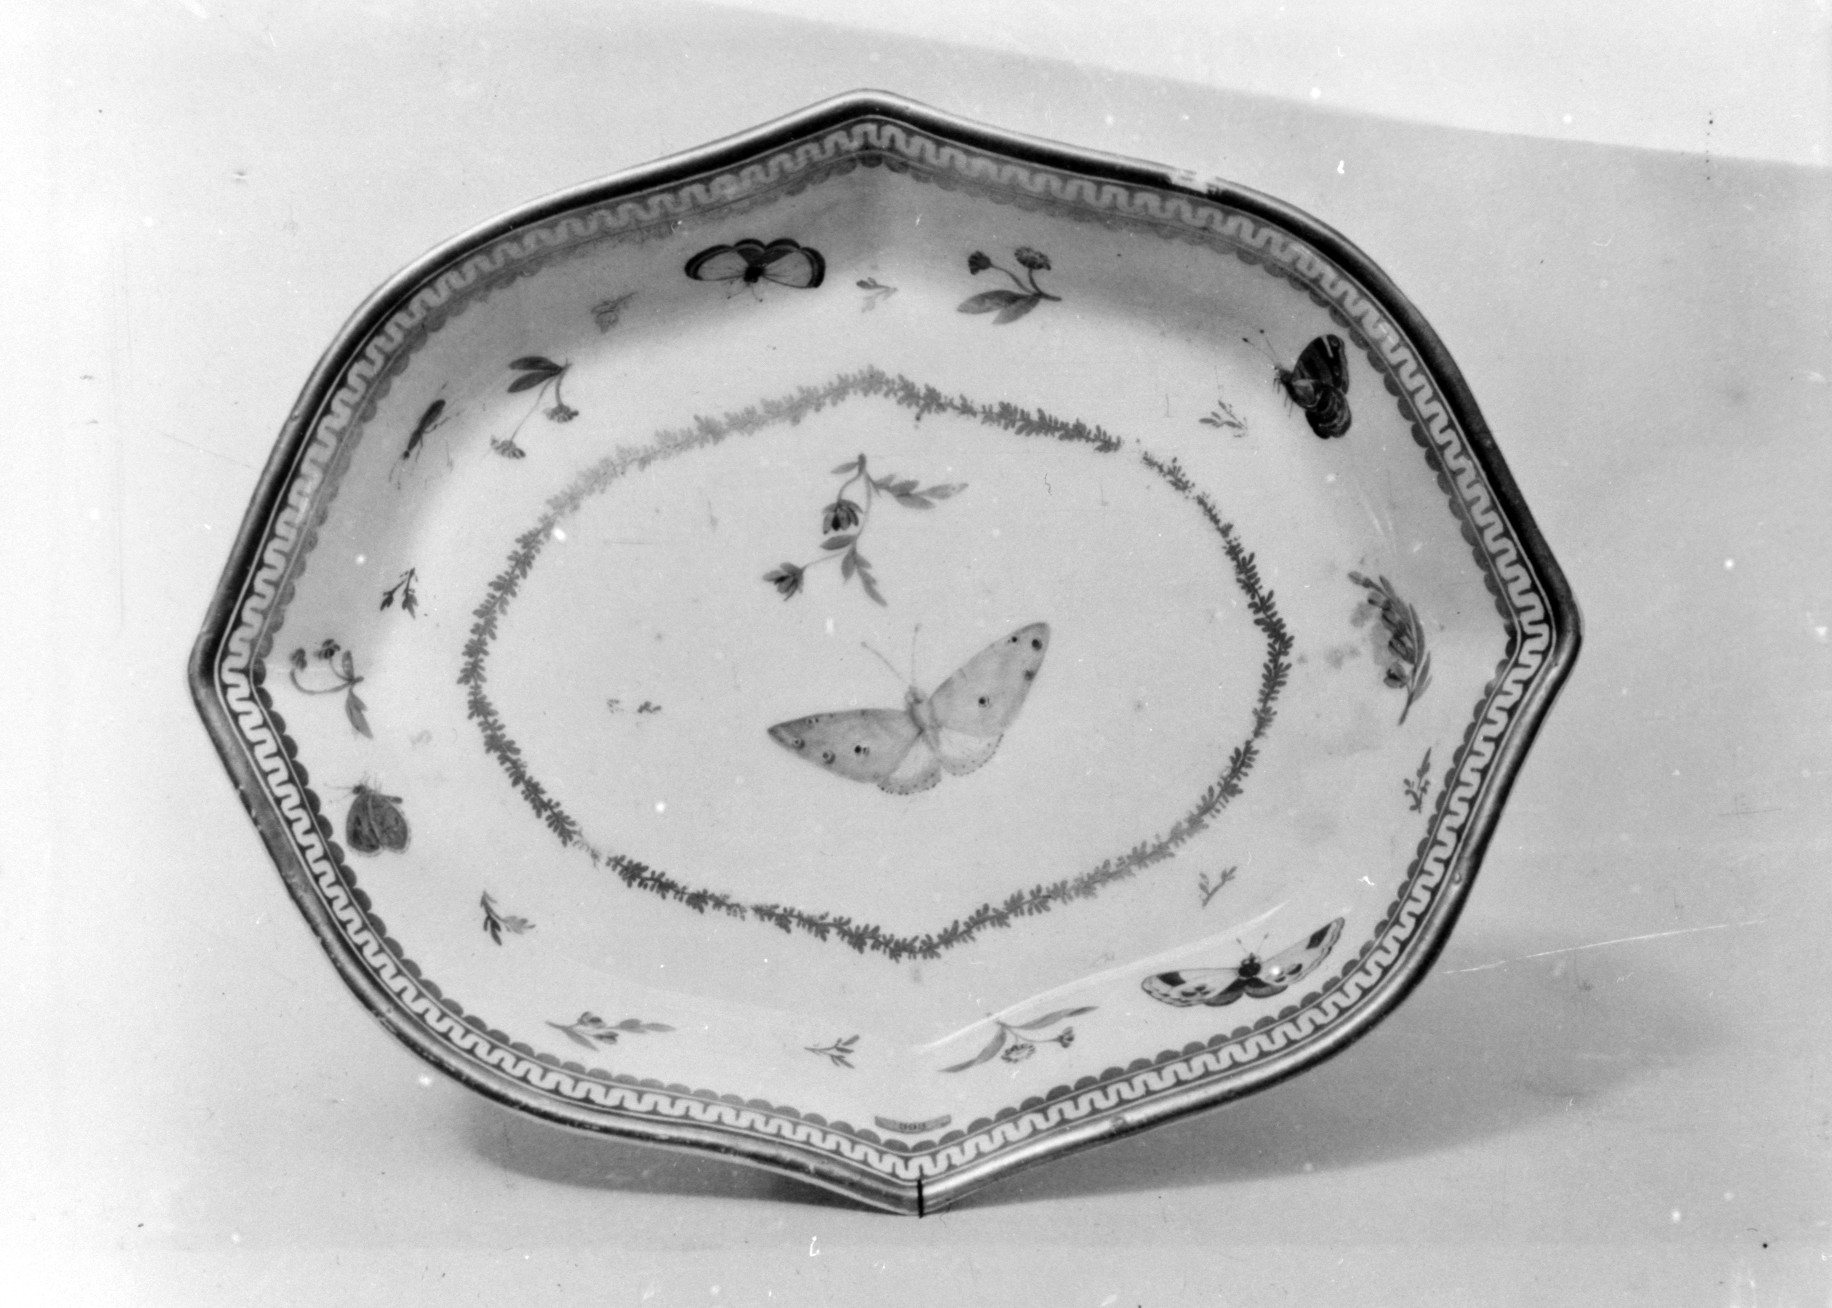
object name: teapot tray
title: Tray (probably for a teapot)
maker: nyon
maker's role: factory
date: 1785-1800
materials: hard paste porcelain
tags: butterflies,flowers